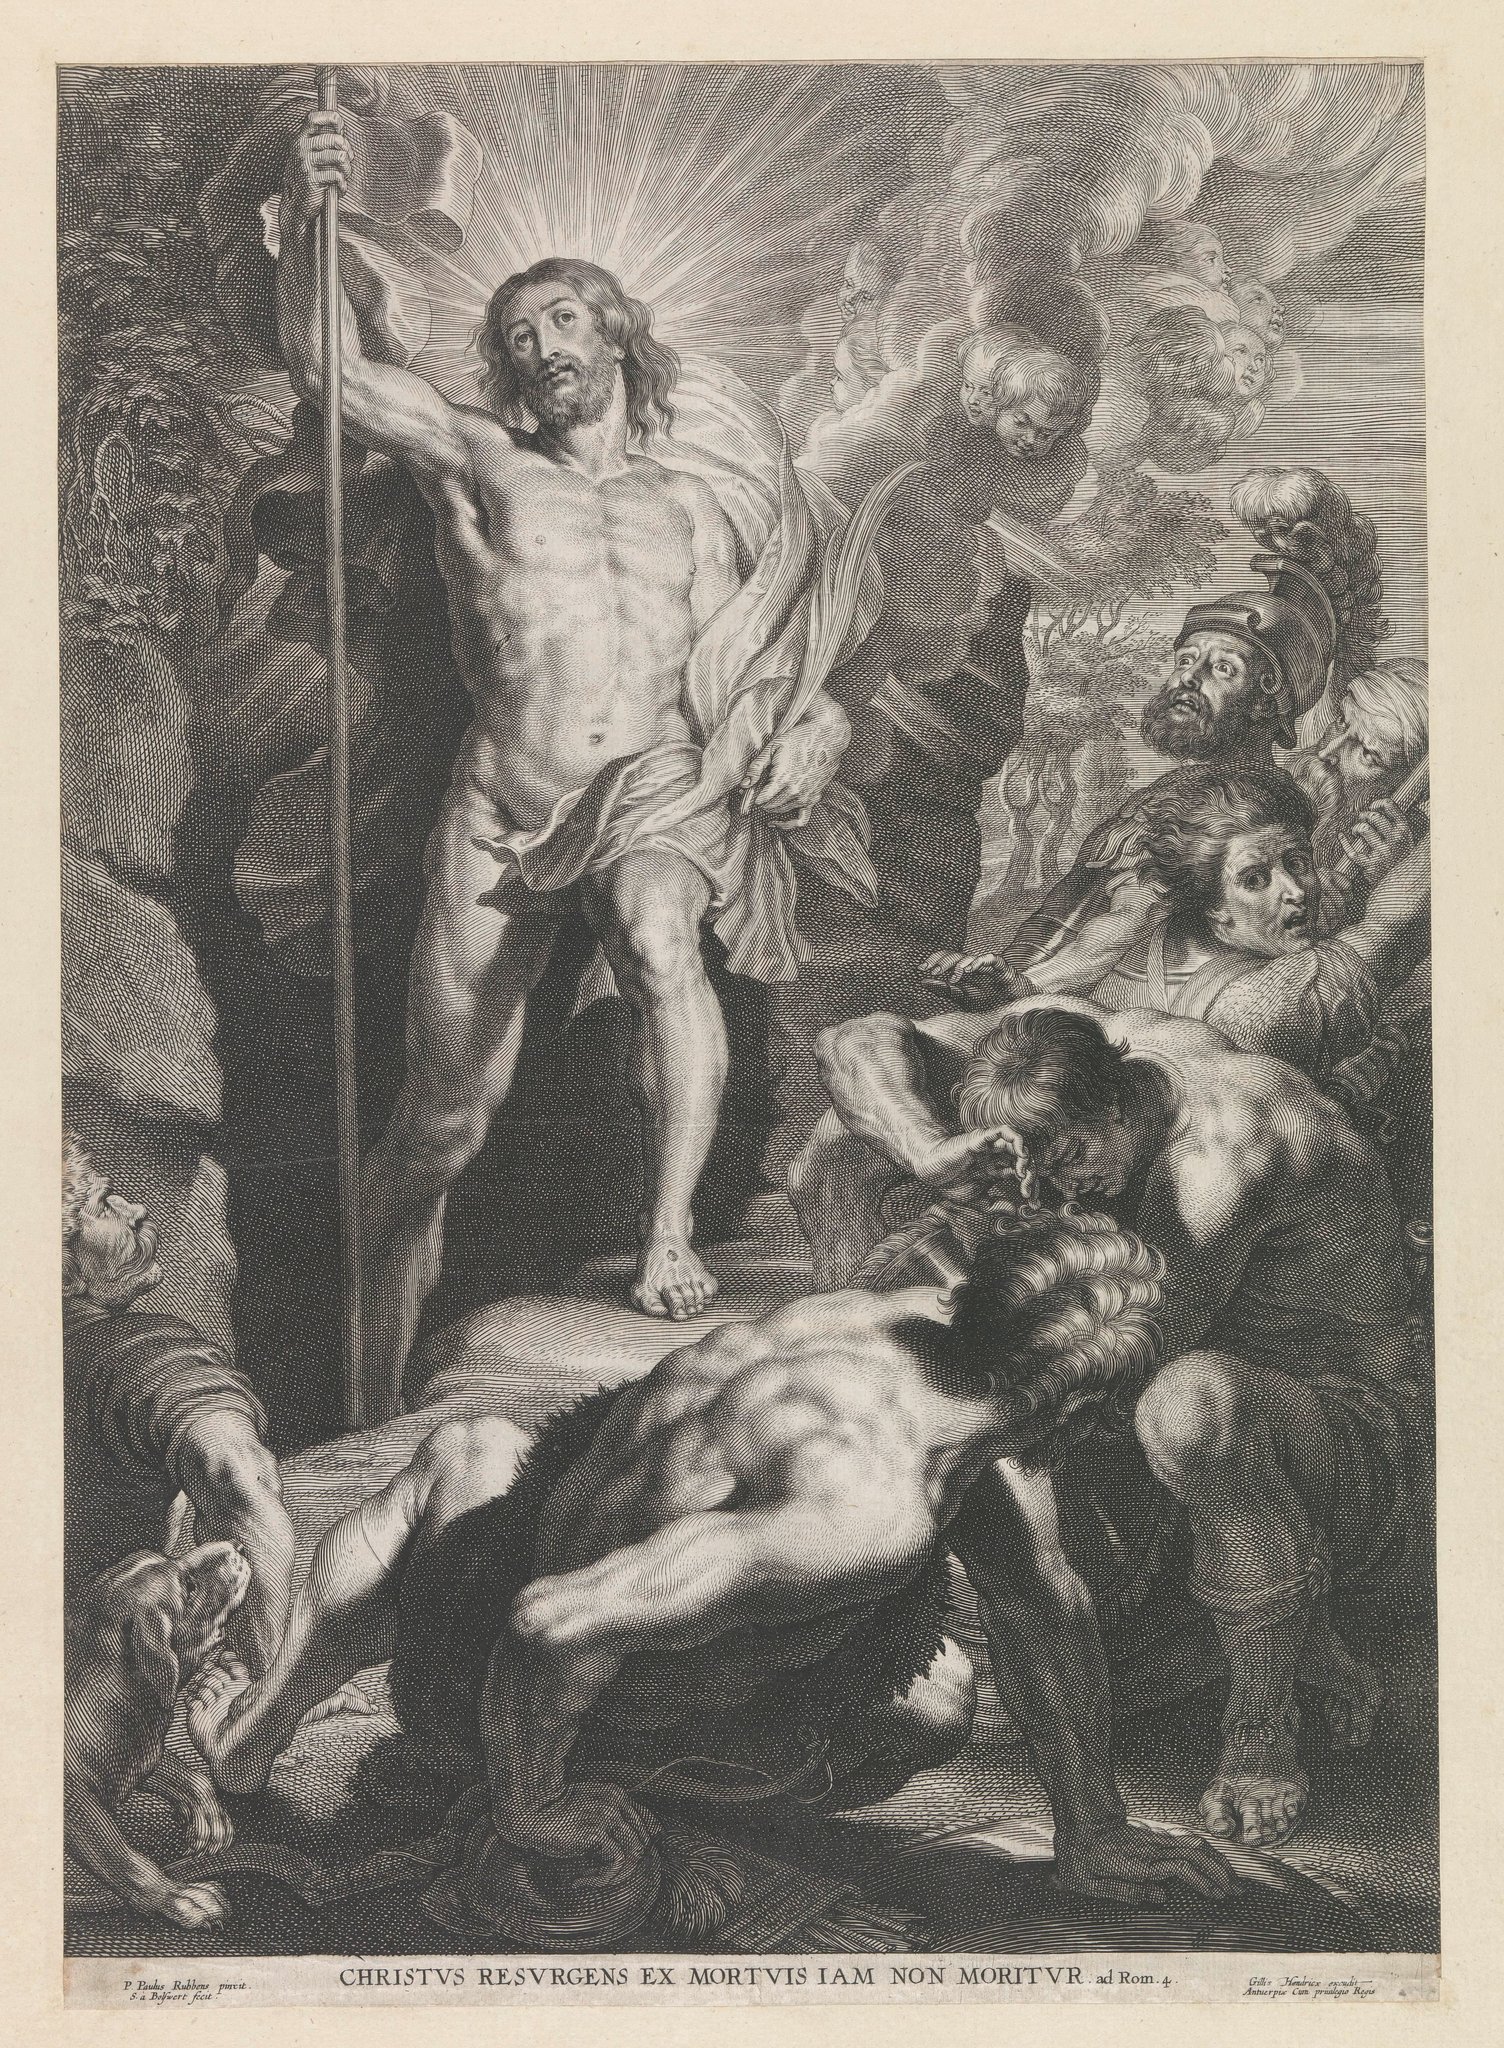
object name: print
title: Christus resurgens ex mortuis iam non mortur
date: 1596-1659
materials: paper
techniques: engraving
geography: antwerp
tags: christ stepping out of the tomb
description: Christus staat op uit het graf met een overwinningsbanier in de hand. Rechts de verschrikte Romeinse soldaten. Deze prent maakt deel uit van een album.